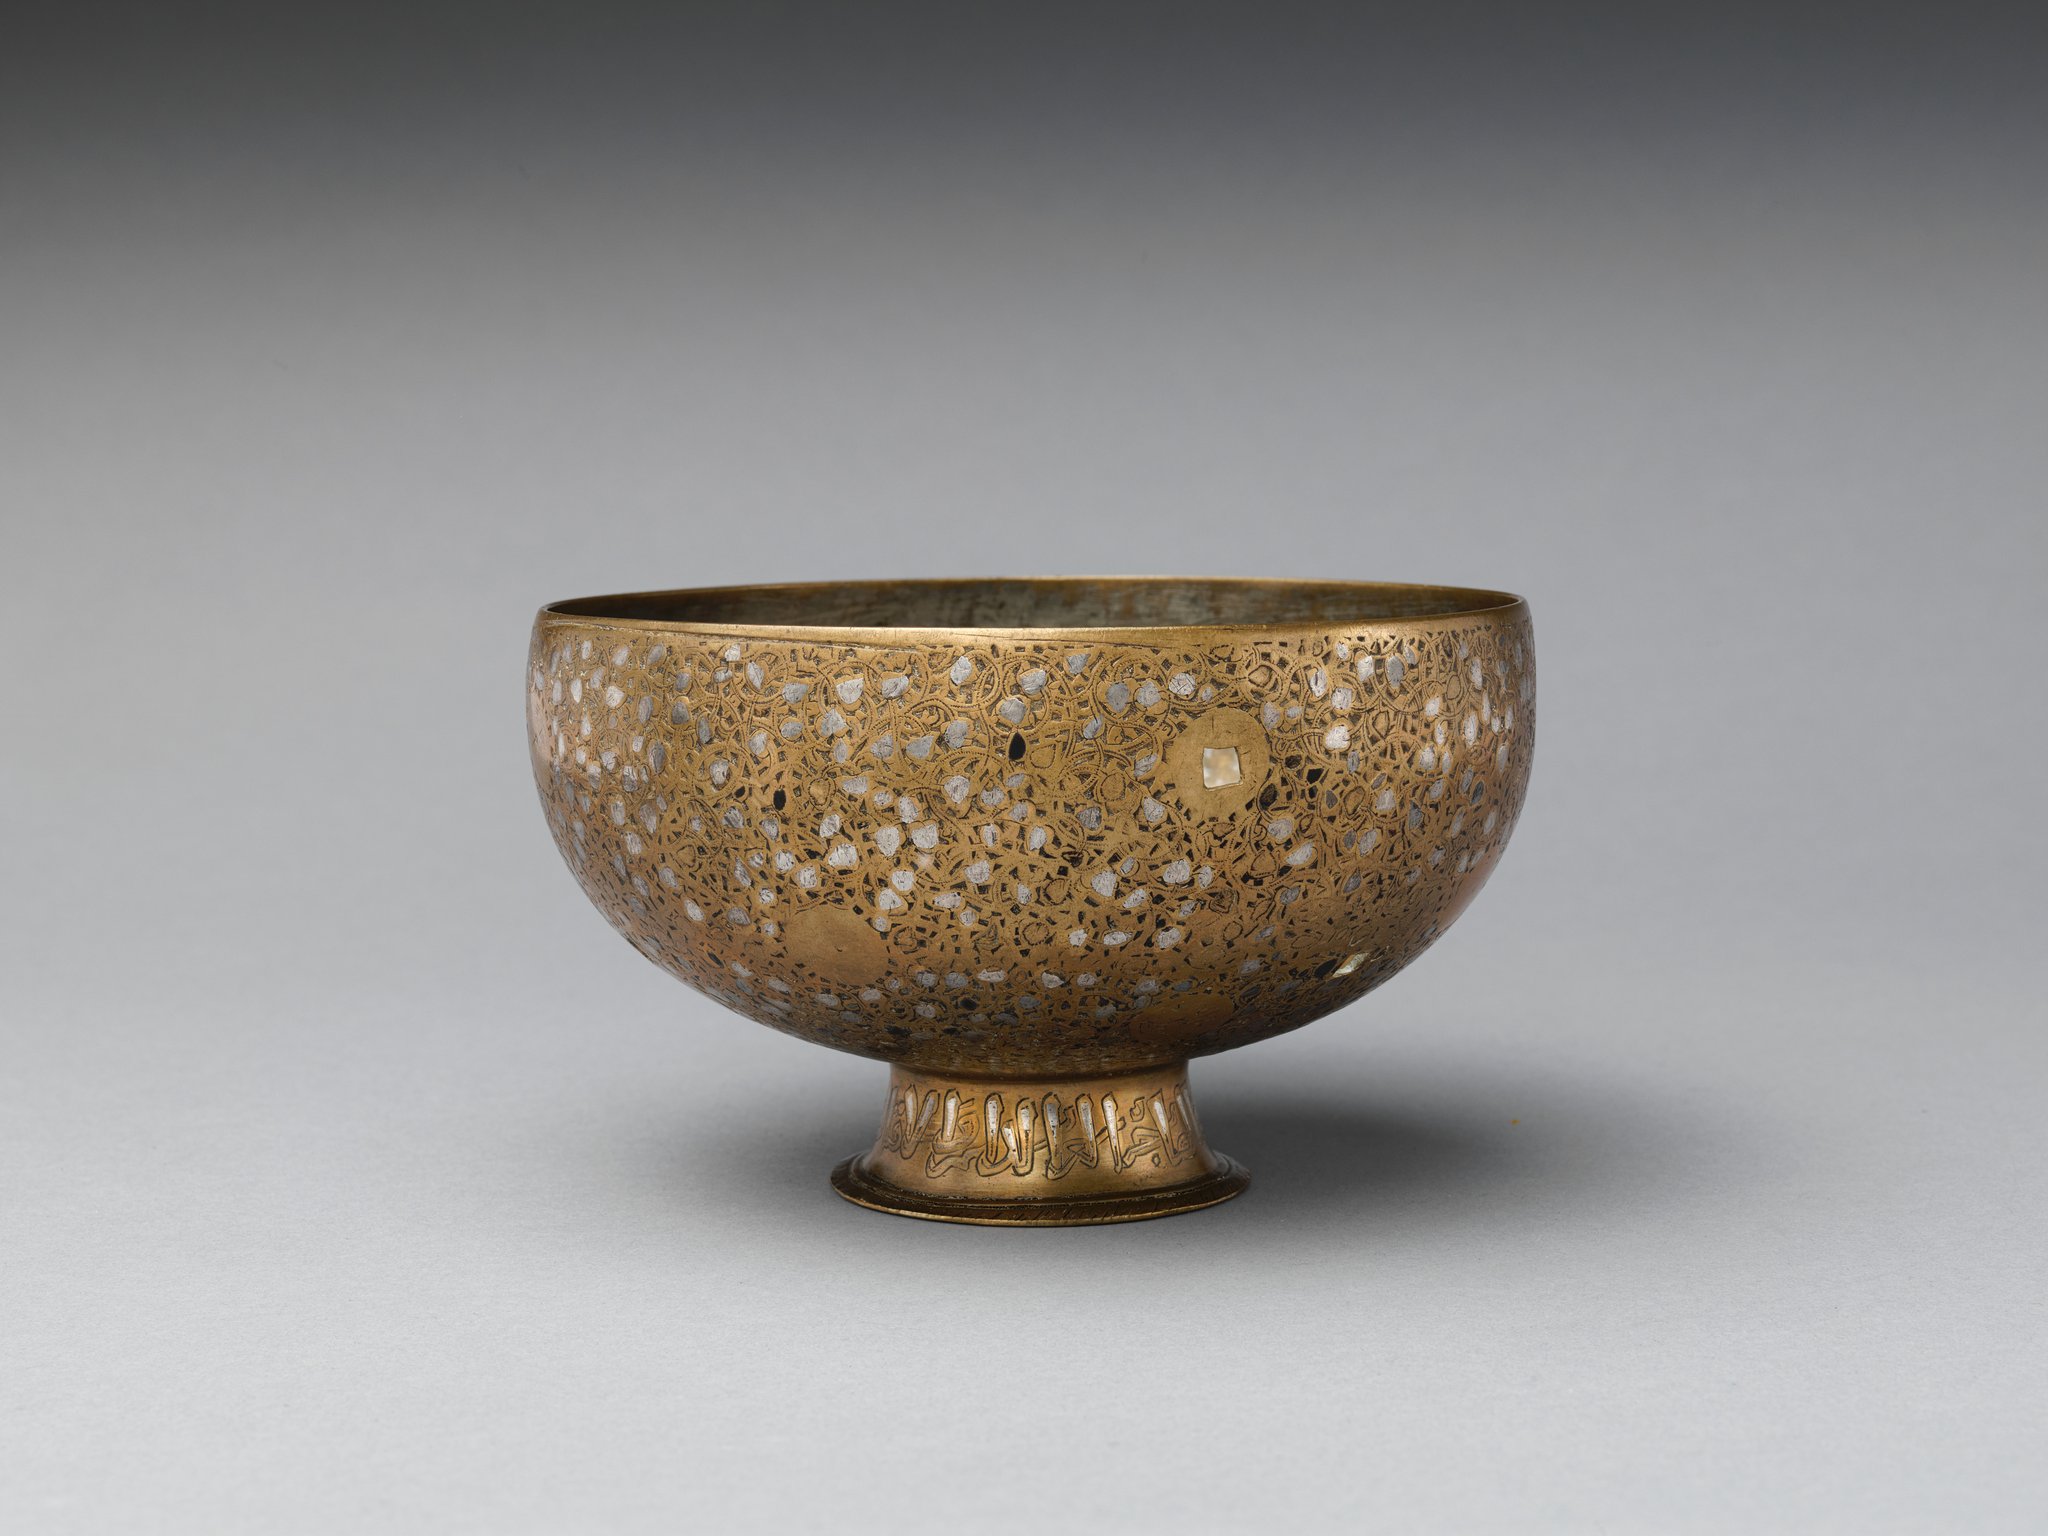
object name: cup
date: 1301-1400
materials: brass, silver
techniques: engraving, inlay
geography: syria